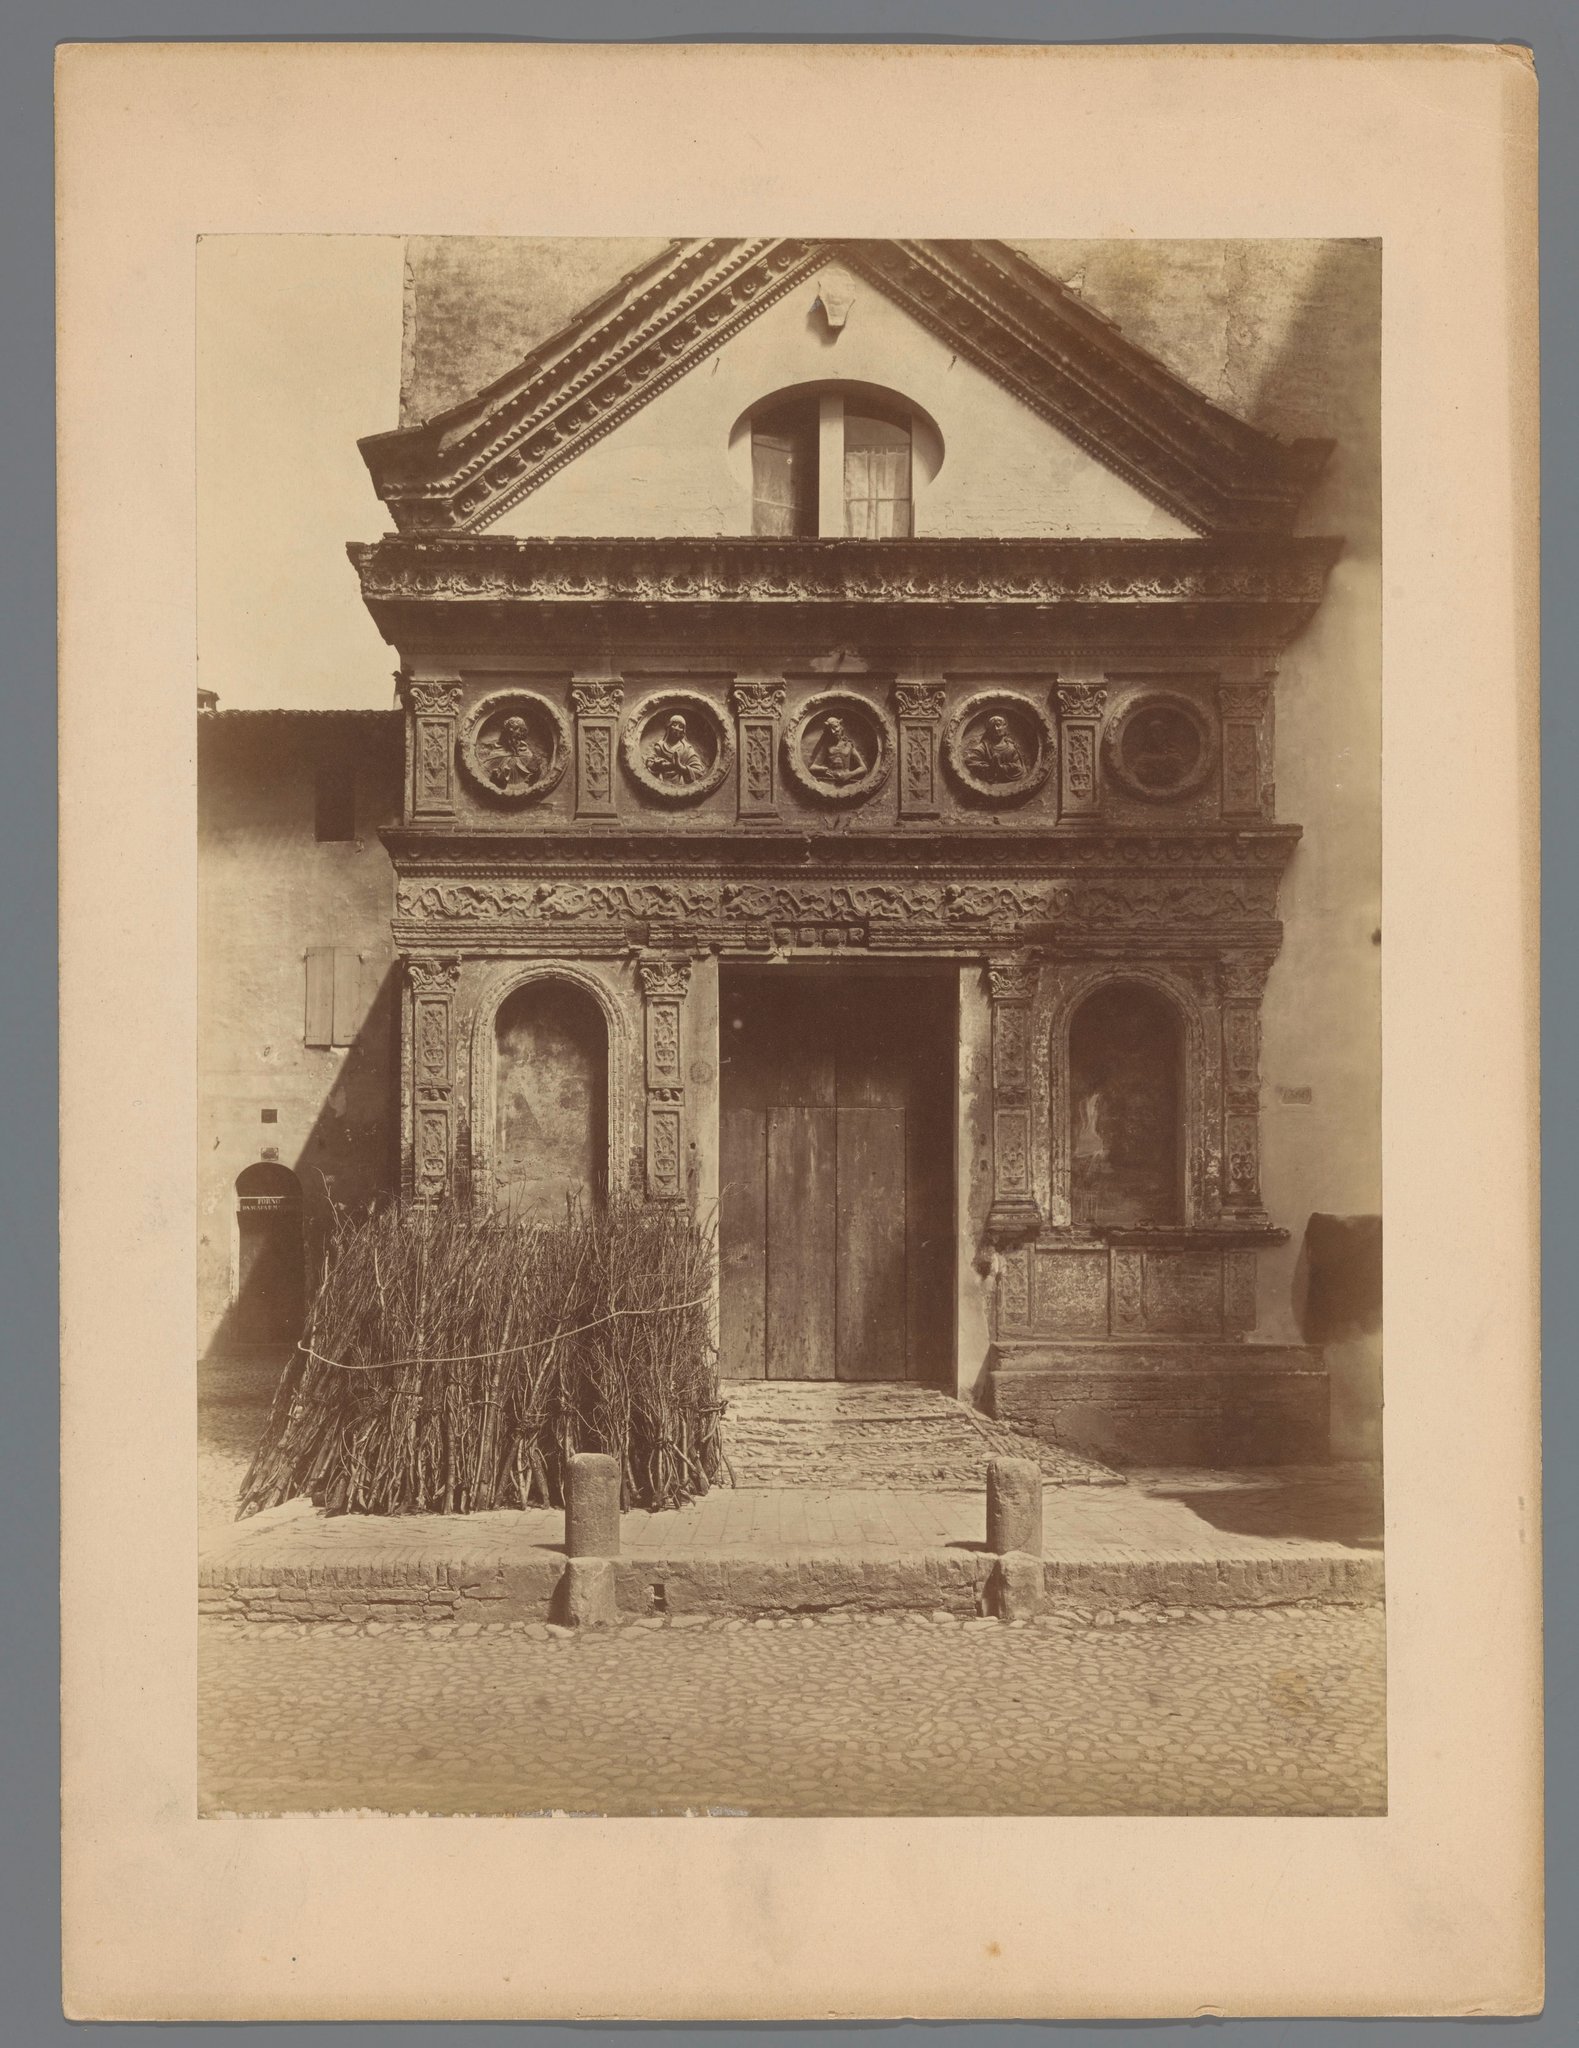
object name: photograph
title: Façade van een gebouw met takkenbossen ervoor, vermoedelijk in Italië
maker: Anonymous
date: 1875-1900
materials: cardboard, photographic support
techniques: albumen print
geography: italy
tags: oven ~ kitchen, shrubs, façade (of house or building), italy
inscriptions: collector's mark: Lugt 3937